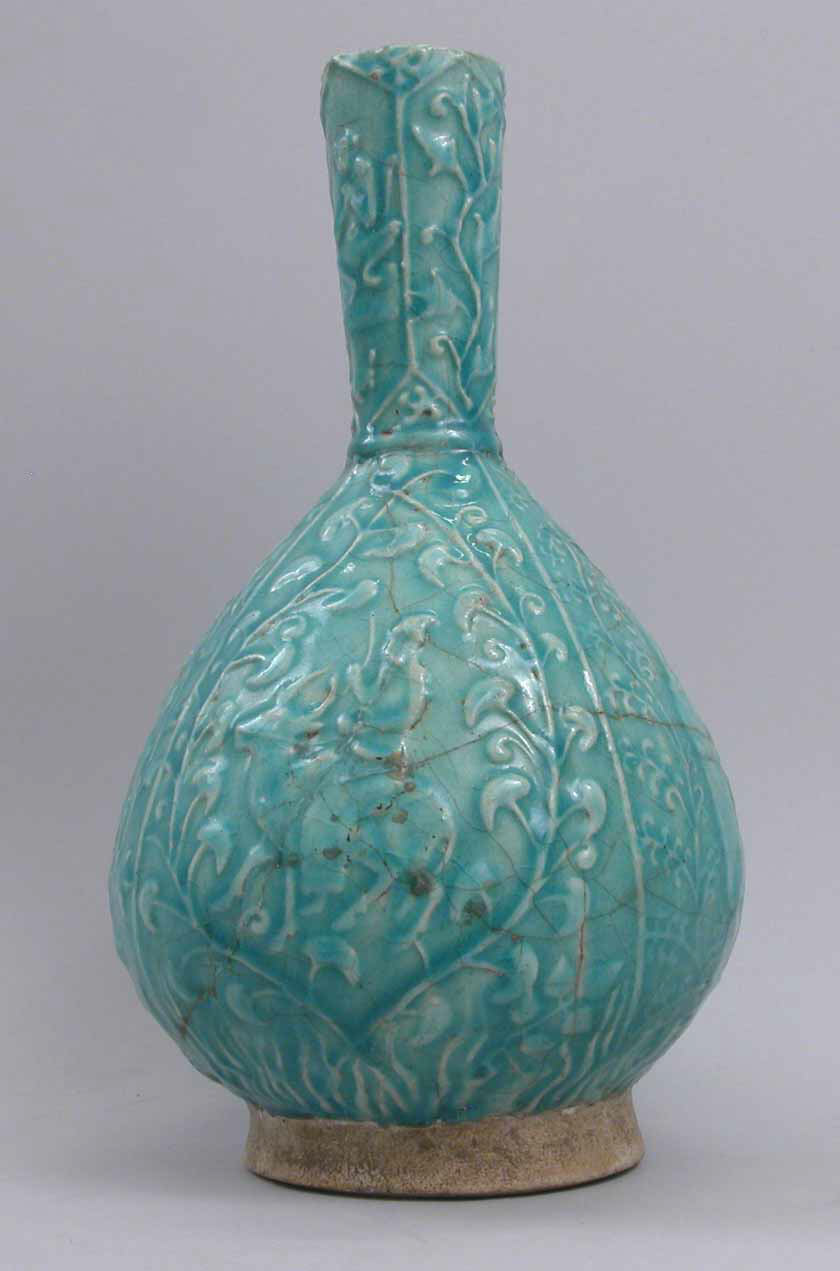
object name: bottle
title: Bottle with Figures Riding Buffaloes or Antilopes, and Monkeys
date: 1401-1500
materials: stonepaste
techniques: glazing, molding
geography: iran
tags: human figures,buffalos